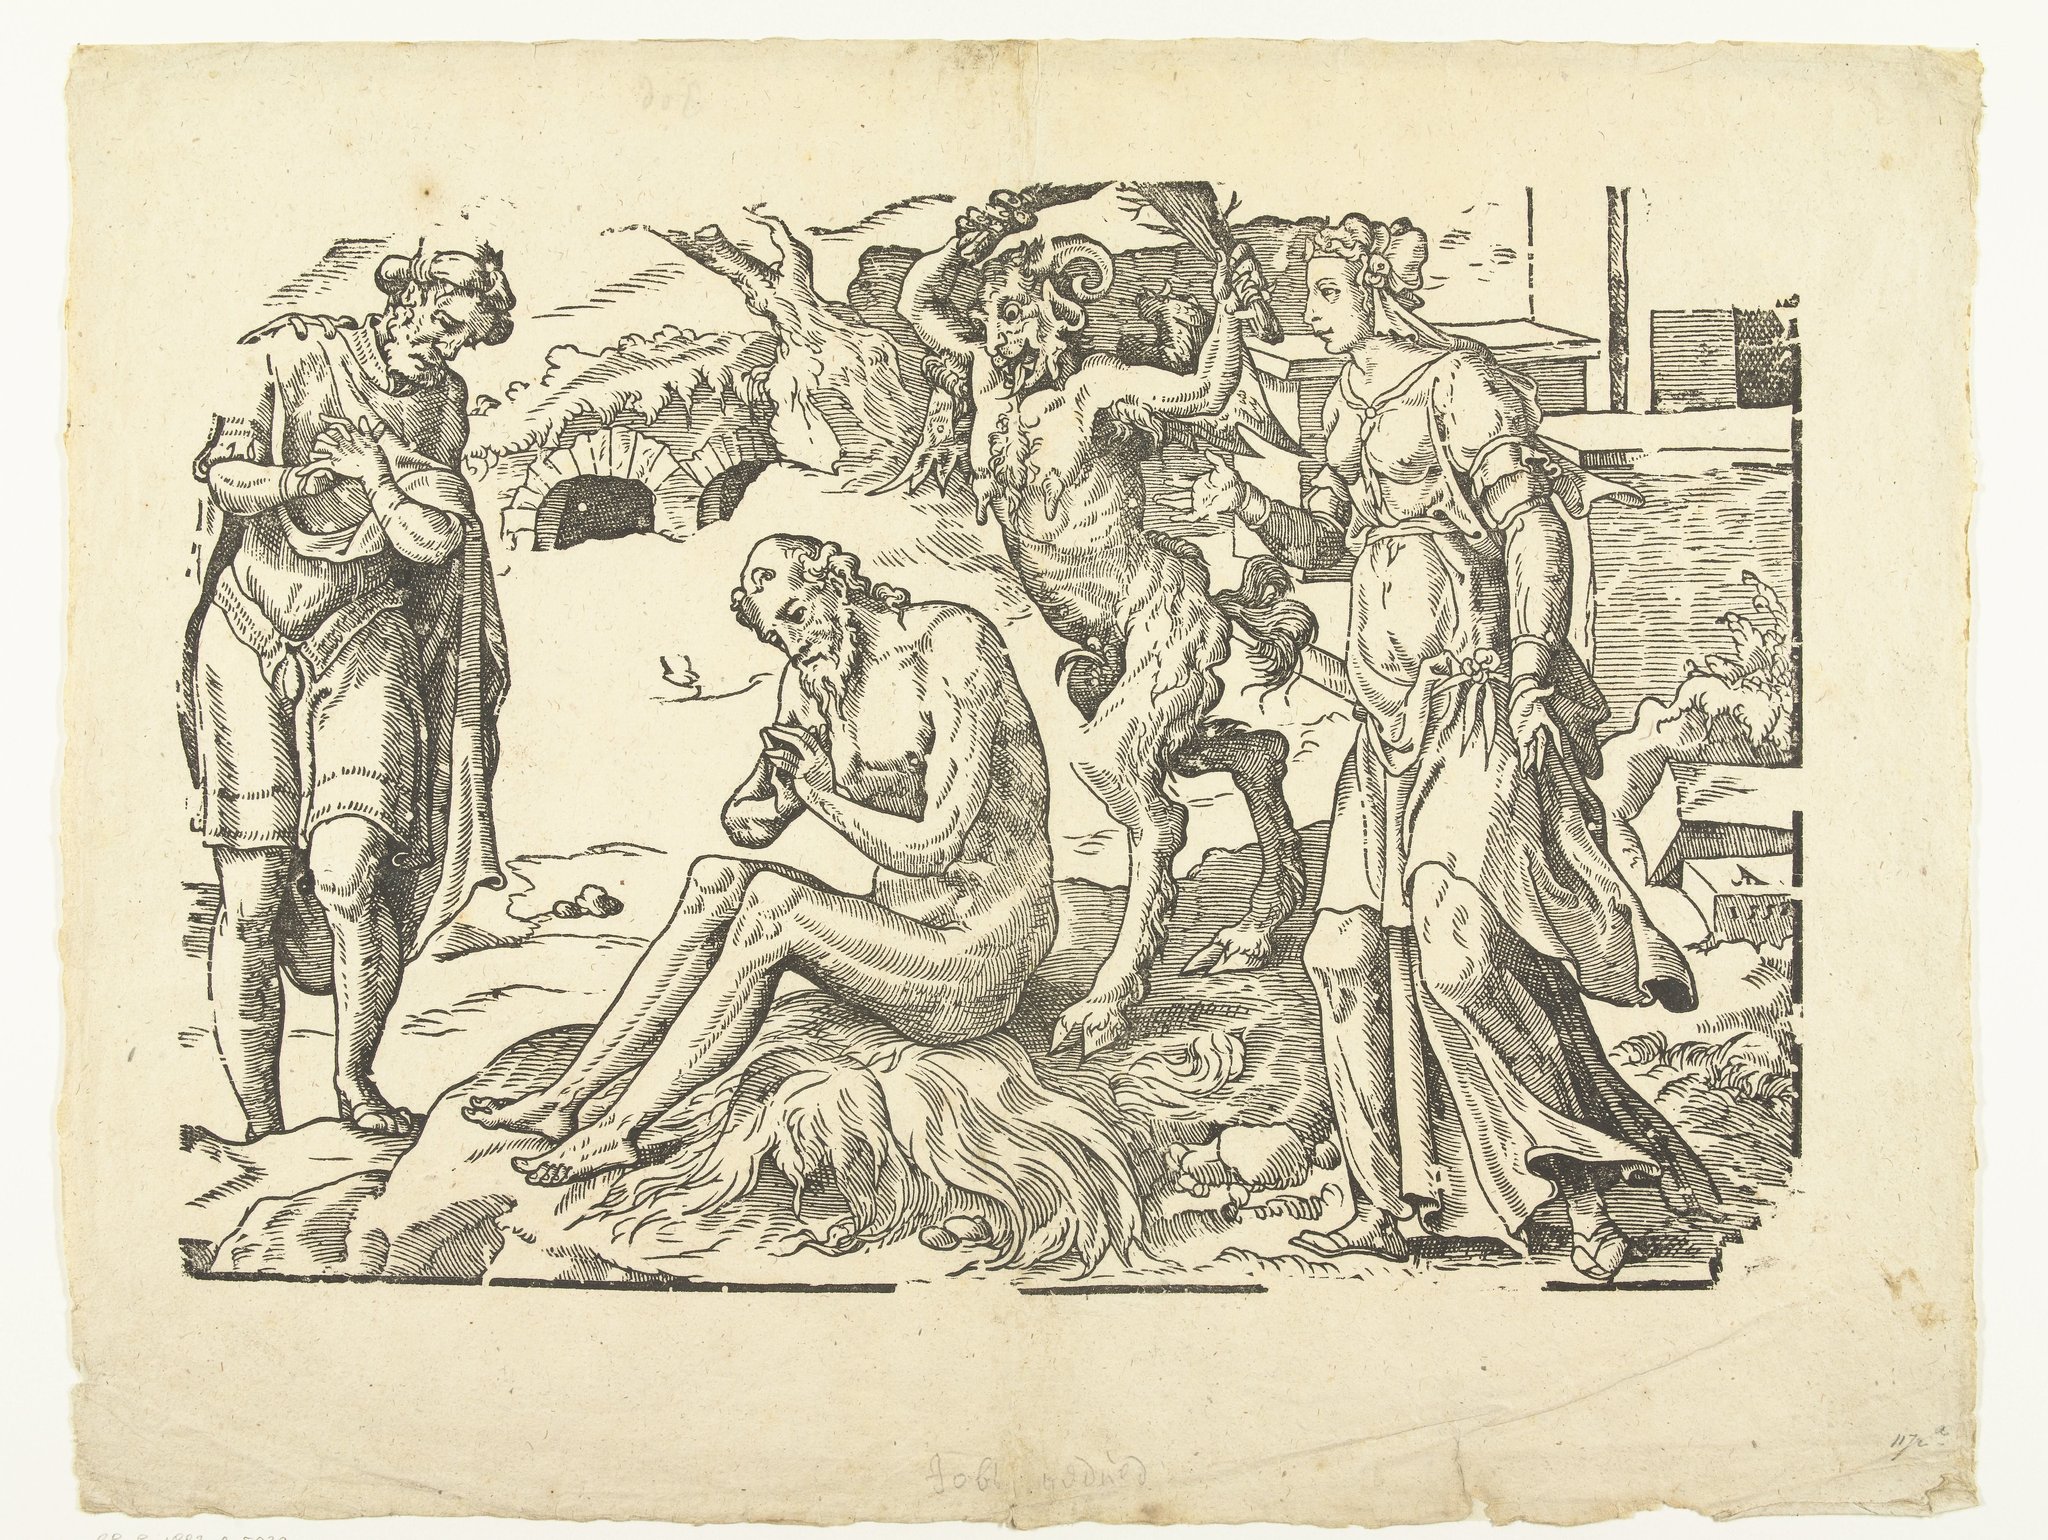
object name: print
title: Job op de mesthoop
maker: monogrammist ai (16e eeuw)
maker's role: print maker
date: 1557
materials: paper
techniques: woodcut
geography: low countries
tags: job on the dunghill visited by his friends (and wife), job on the dunghill with satan (or devils) abusing and tormenting him; job's wife may be present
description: Job zittend naakt op een mesthoop, wordt door de duivel gegeseld. Links van h zijn vrouw, rechts een vriend.